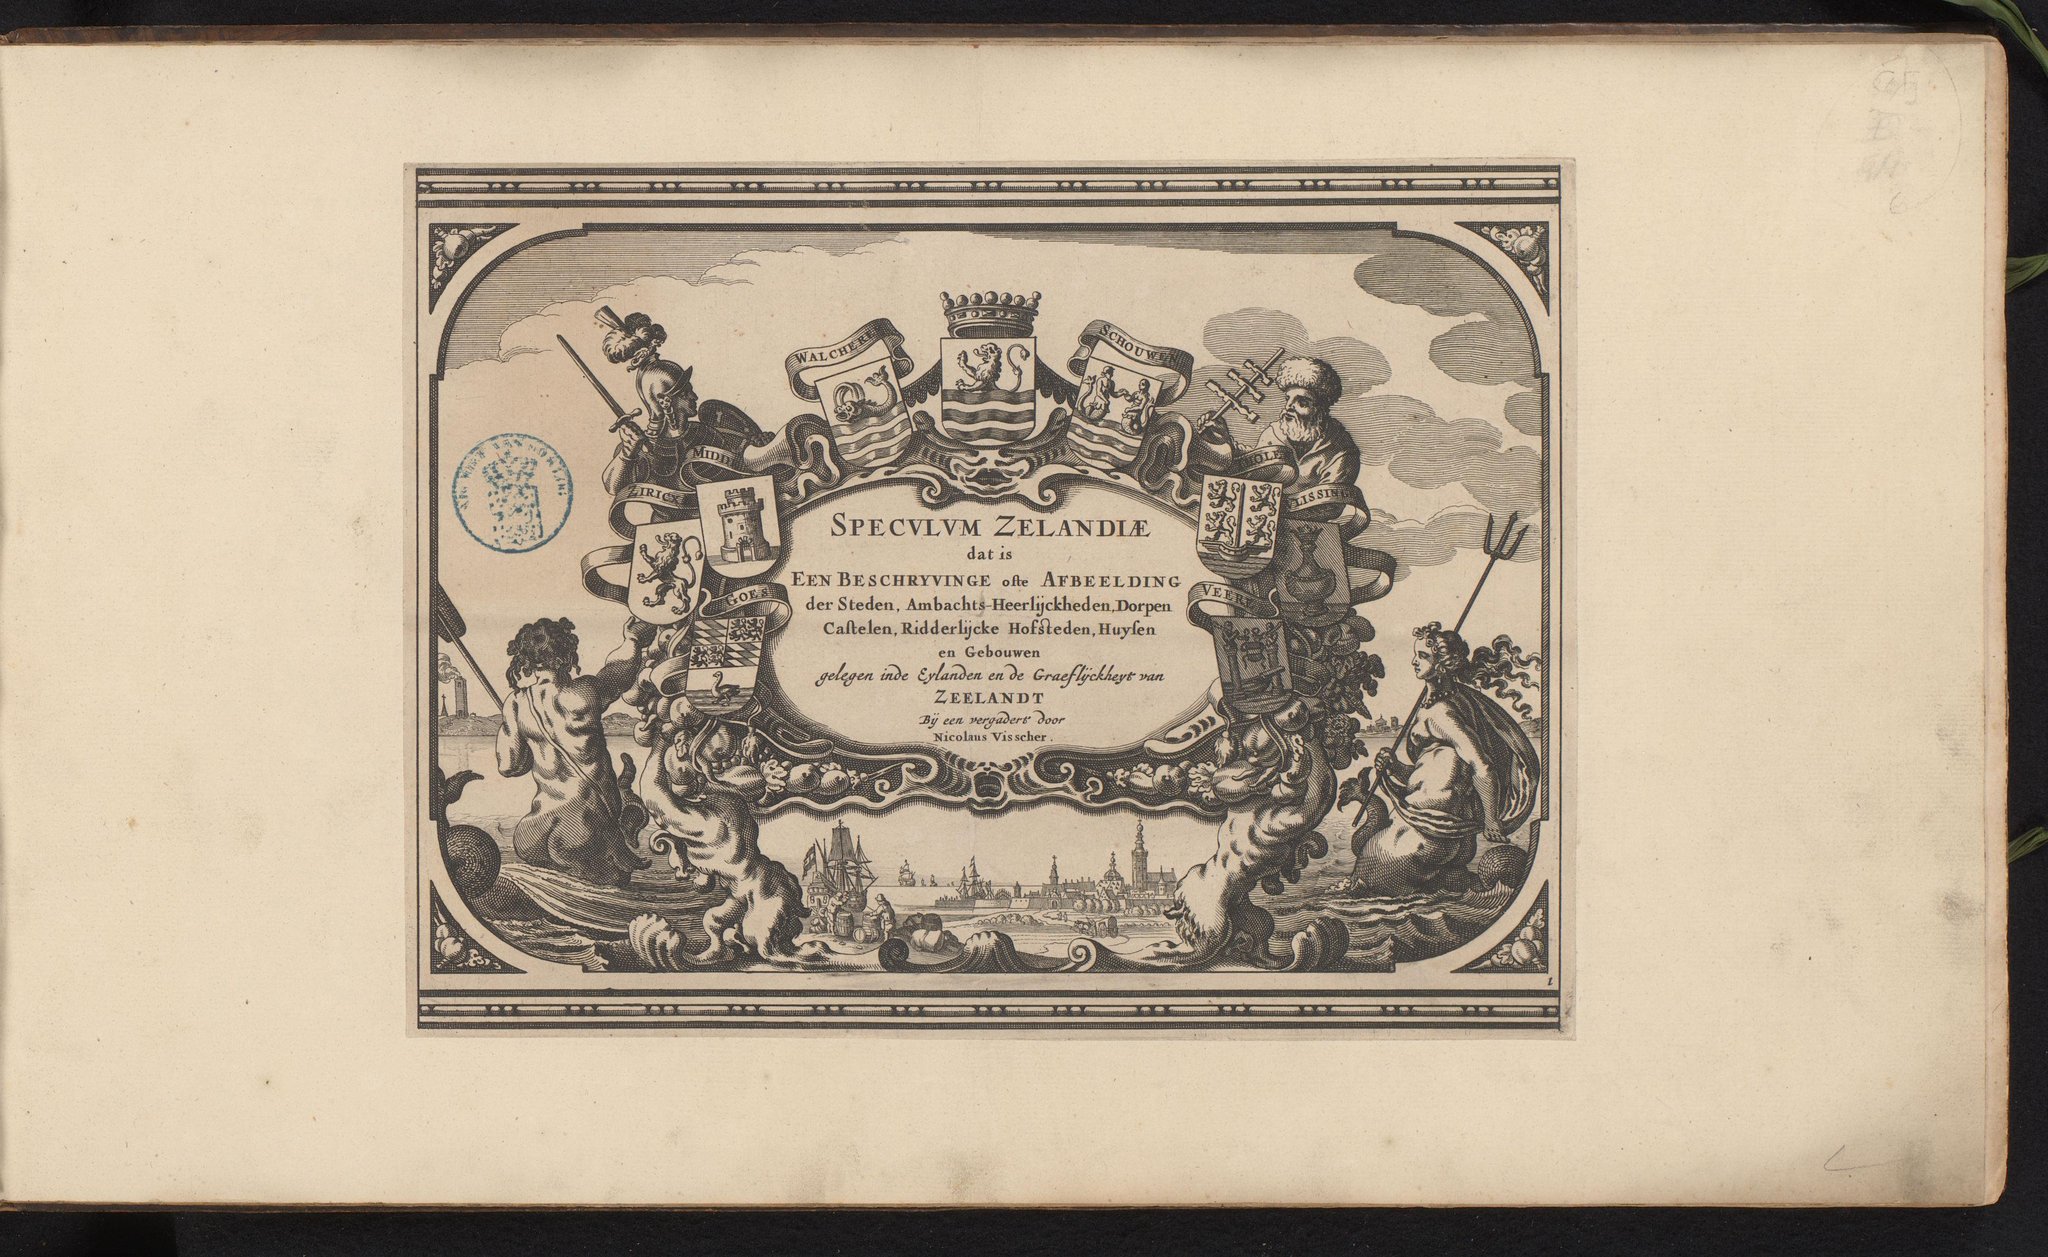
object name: titelprent, frontispice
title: Speculum Zelandiae dat is een Beschryvinge ofte afbeelding der steden, ambachts-heerlijckheden, dorpen, castelen, ridderlijcke hofsteden, huysen en gebouwen gelegen inde eylanden en de graeflijckheyt van Zeelandt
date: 1662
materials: paper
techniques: etching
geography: amsterdam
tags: coat of arms (as symbol of the state, etc.), city-view, and landscape with man-made constructions, title-page, seaman, ornament ~ cartouche, knight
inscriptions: collector's mark: Lugt 2166, collector's mark: Lugt 195, collector's mark:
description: Cartouche met de titel van de serie gedragen door de zee. Bovenop het wapen van Zeeland en de wapens van de belangrijkste steden in de provincie. Daarbij een ridder en een zeeman. De cartouche wordt geflankeerd door een man en vrouw met vissenstaart en in hun hand een peddel en drietand. Onderaan een stadsgezicht. De prent maakt deel uit van een album.